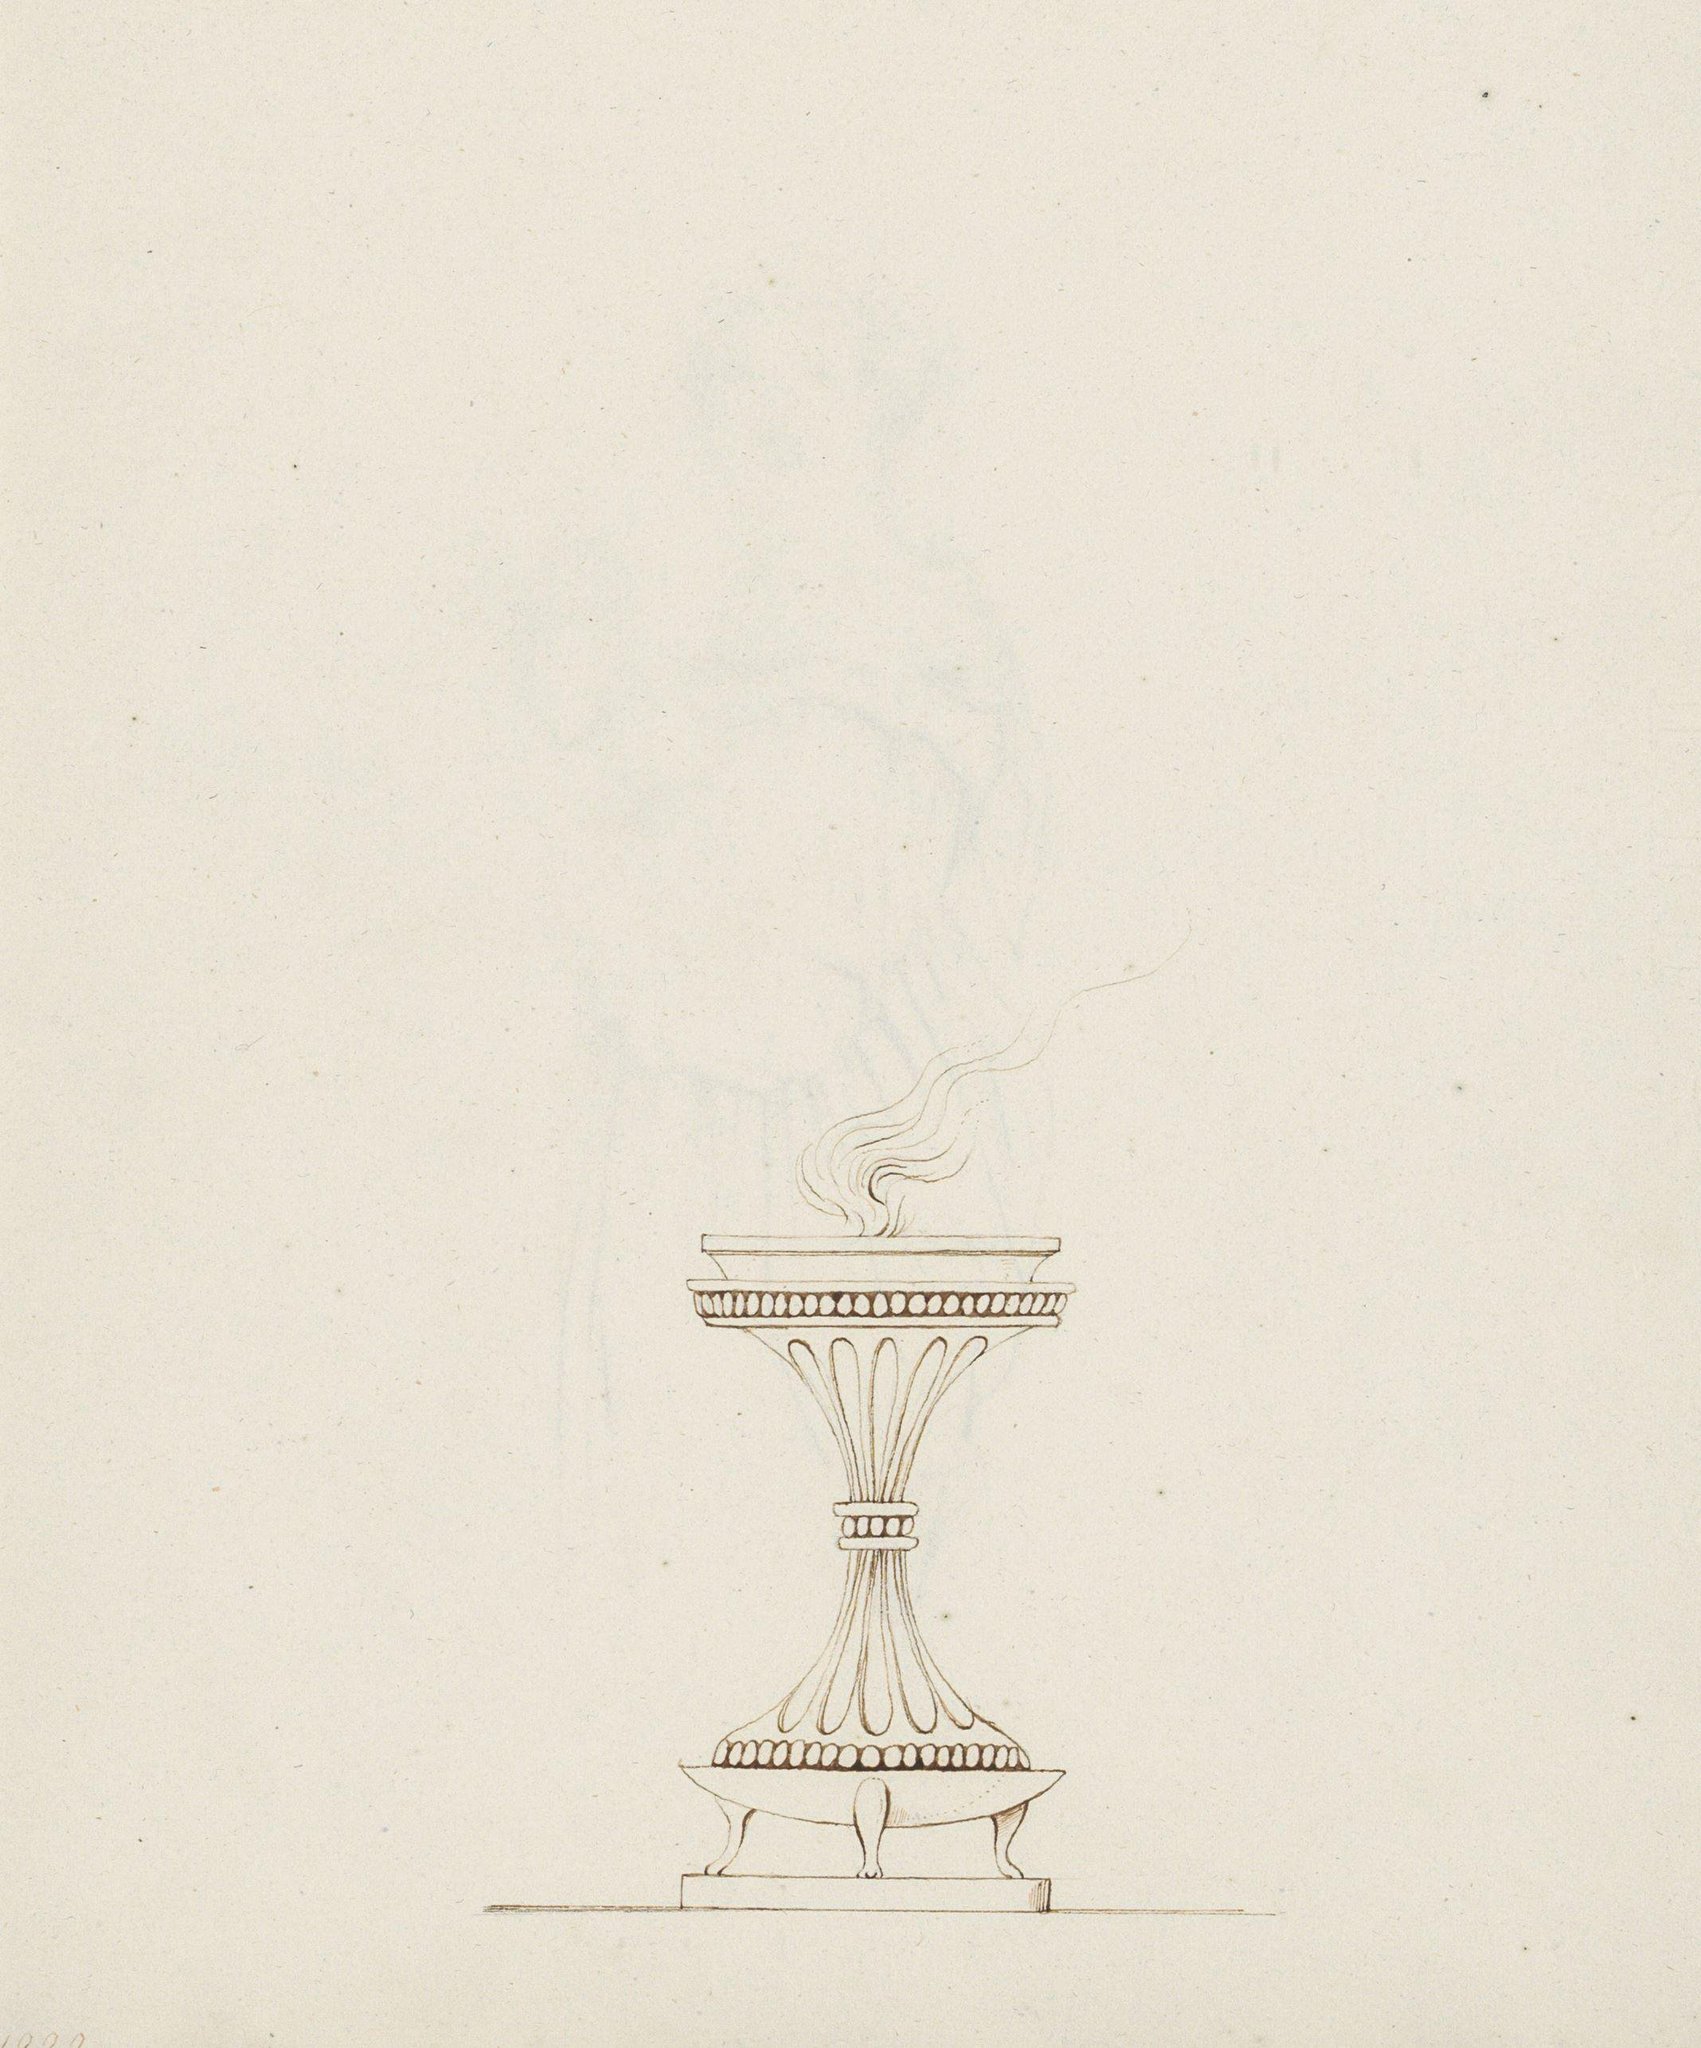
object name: sketchbook leaf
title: Offerstandaard waaruit rook opstijgt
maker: jonkvrouw elisabeth kemper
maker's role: draughtsman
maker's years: 1799-1871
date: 1822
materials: ink, paper, pencil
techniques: pen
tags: sacrifice ~ greek religion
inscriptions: date: ‘1822’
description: Blad 49 recto uit een schetsboek met 94 bladen.